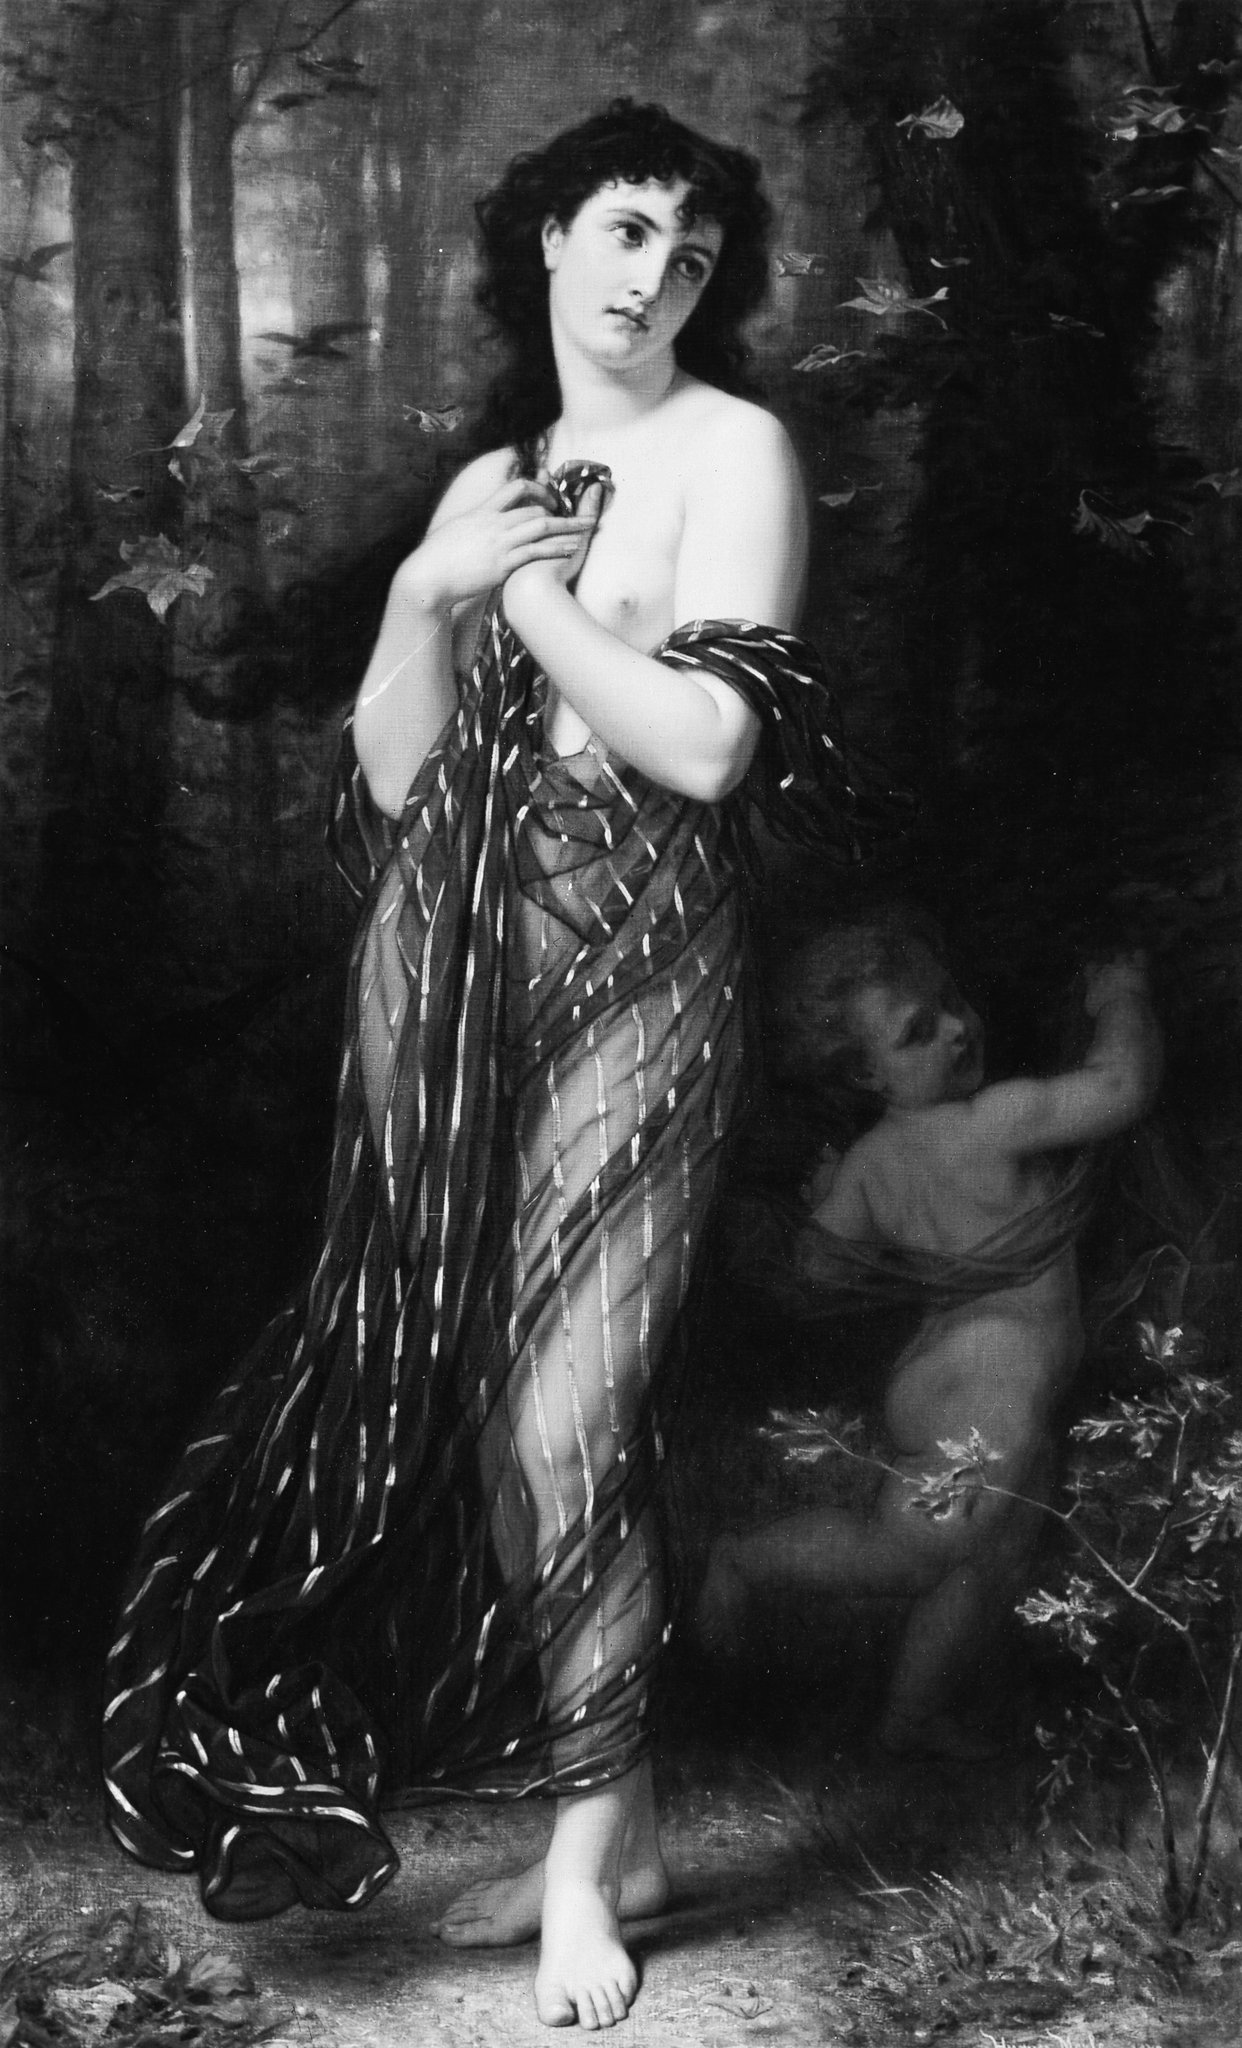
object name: painting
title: Falling Leaves, Allegory of Autumn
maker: hugues merle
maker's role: artist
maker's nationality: french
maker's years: 1823-1881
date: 1872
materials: canvas, oil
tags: children,female nudes,autumn,allegory